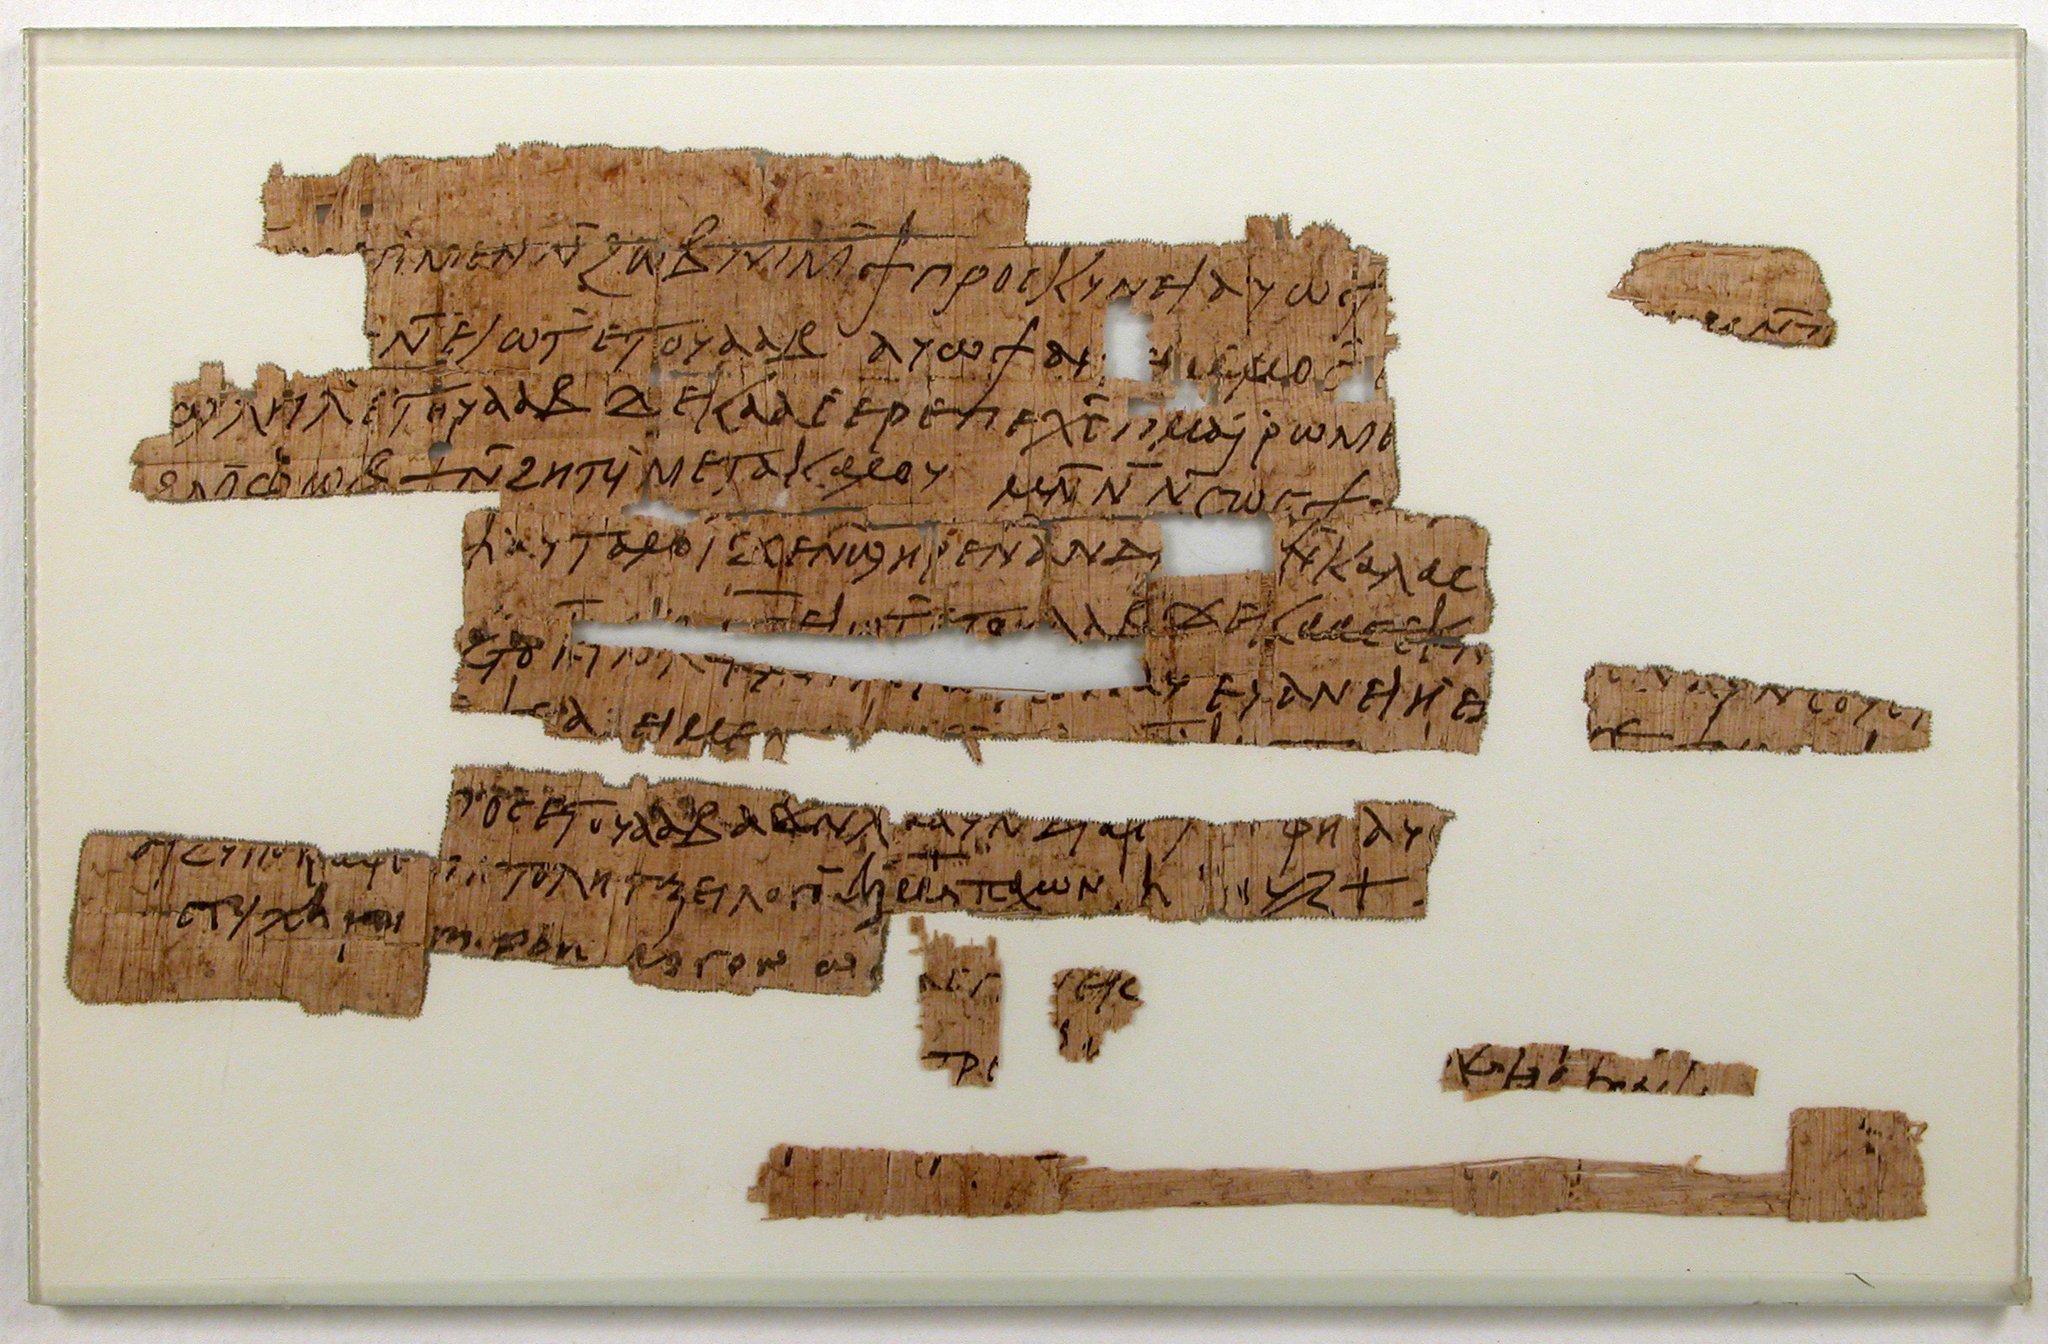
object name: fragment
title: Papyri Fragments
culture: coptic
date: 601-700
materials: ink, papyrus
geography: egypt